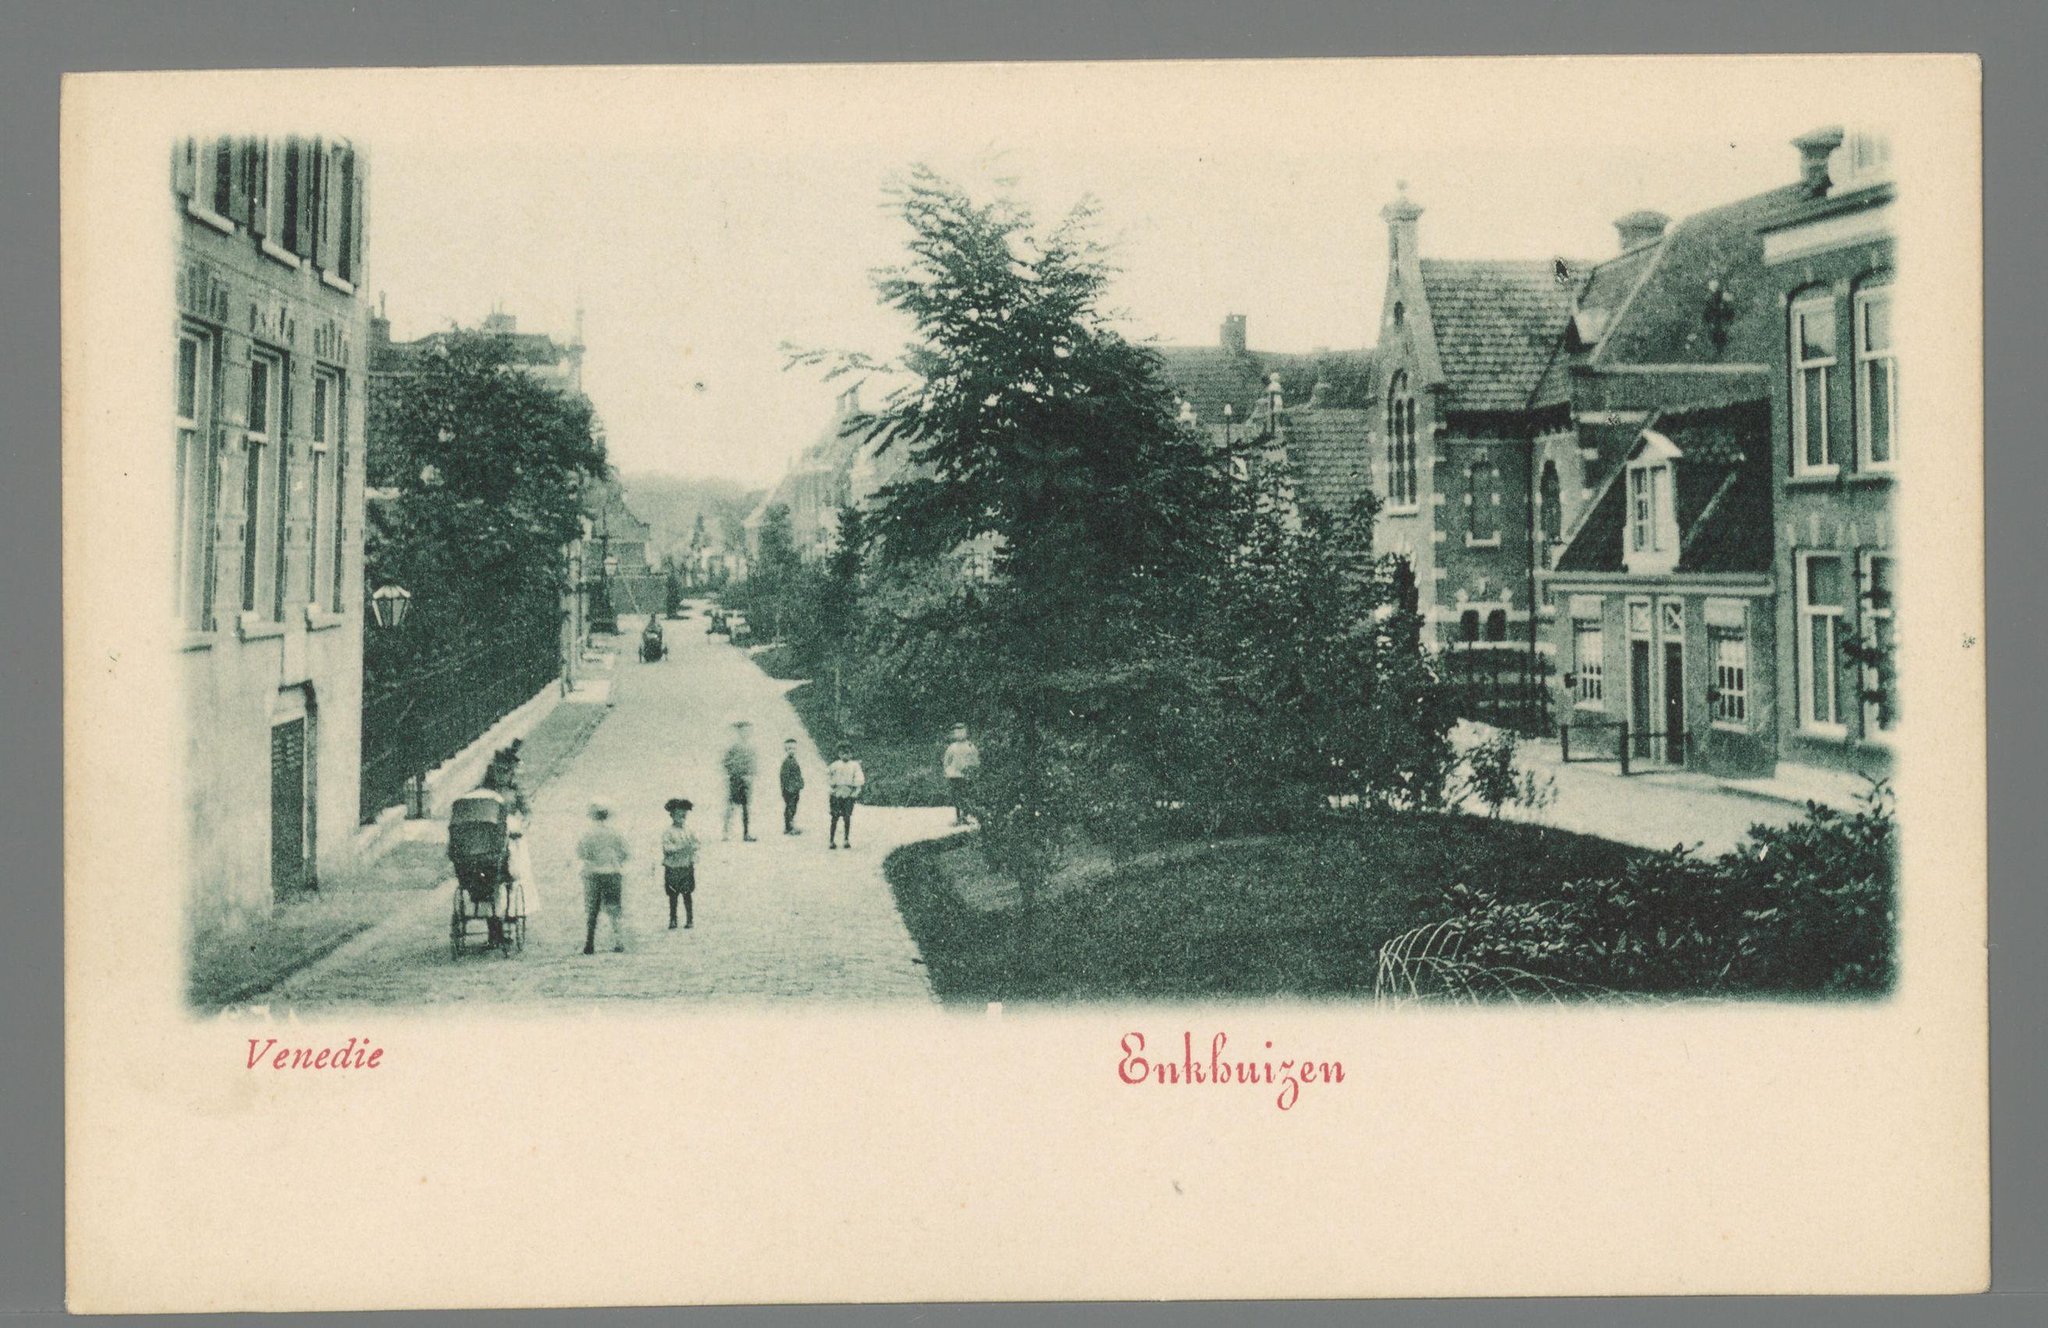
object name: photomechanical print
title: Venedie. Enkhuizen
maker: Anonymous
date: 1892-1905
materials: cardboard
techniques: photograph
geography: enkhuizen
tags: city-view, and landscape with man-made constructions, street, enkhuizen